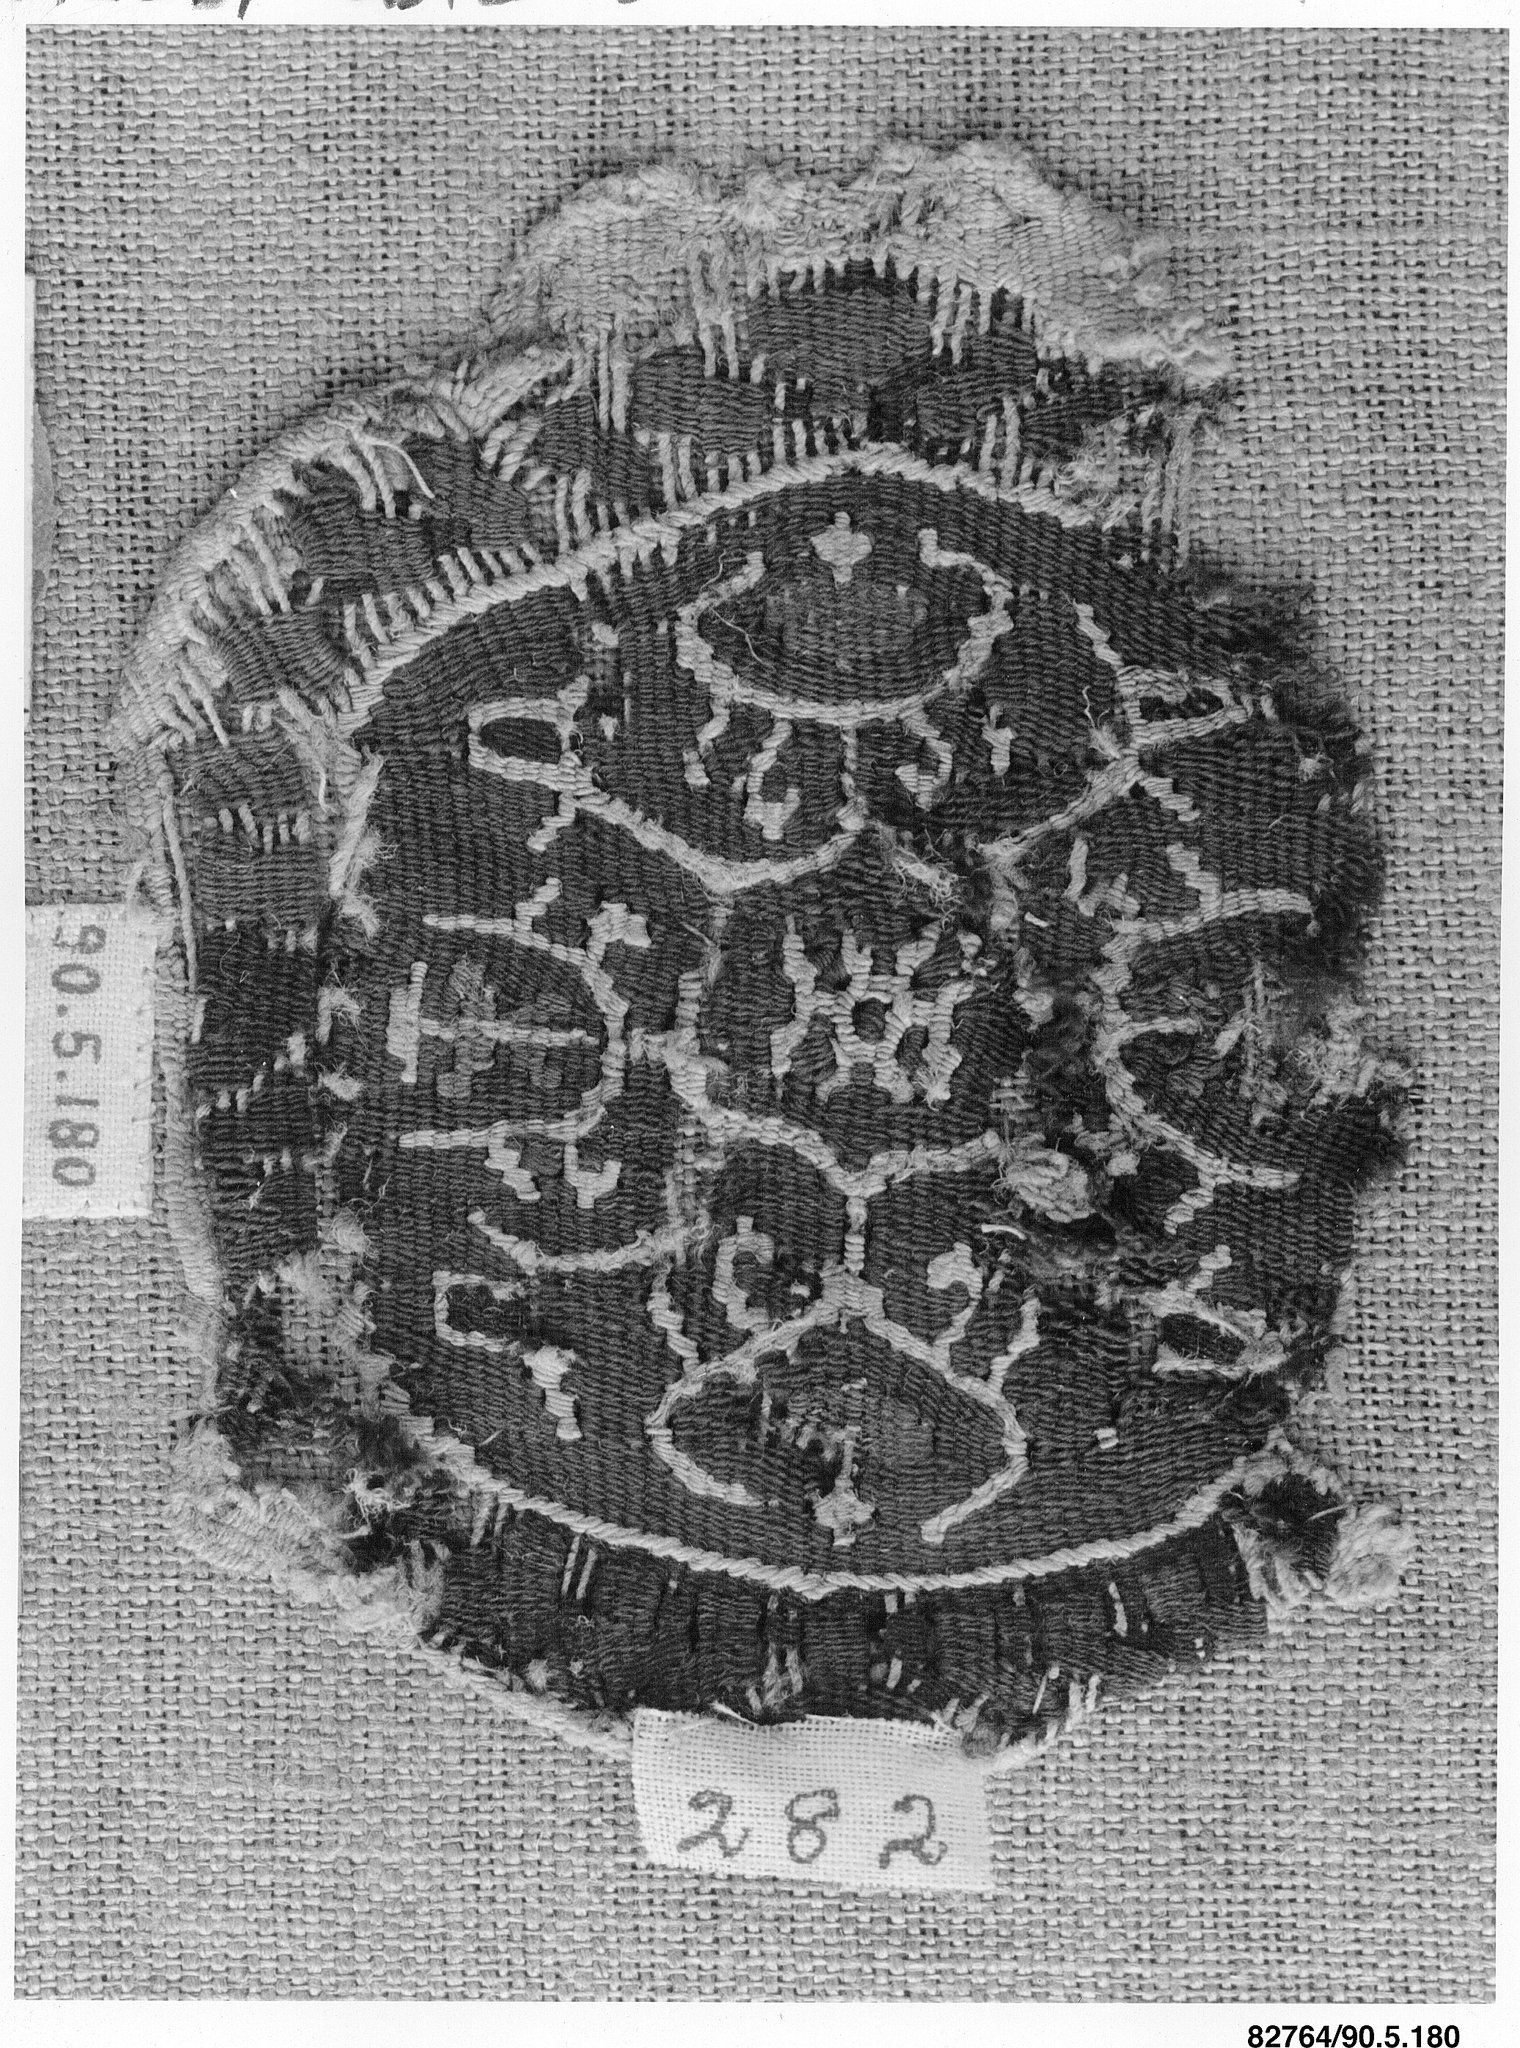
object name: textile fragment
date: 401-600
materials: linen, wool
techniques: weave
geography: egypt